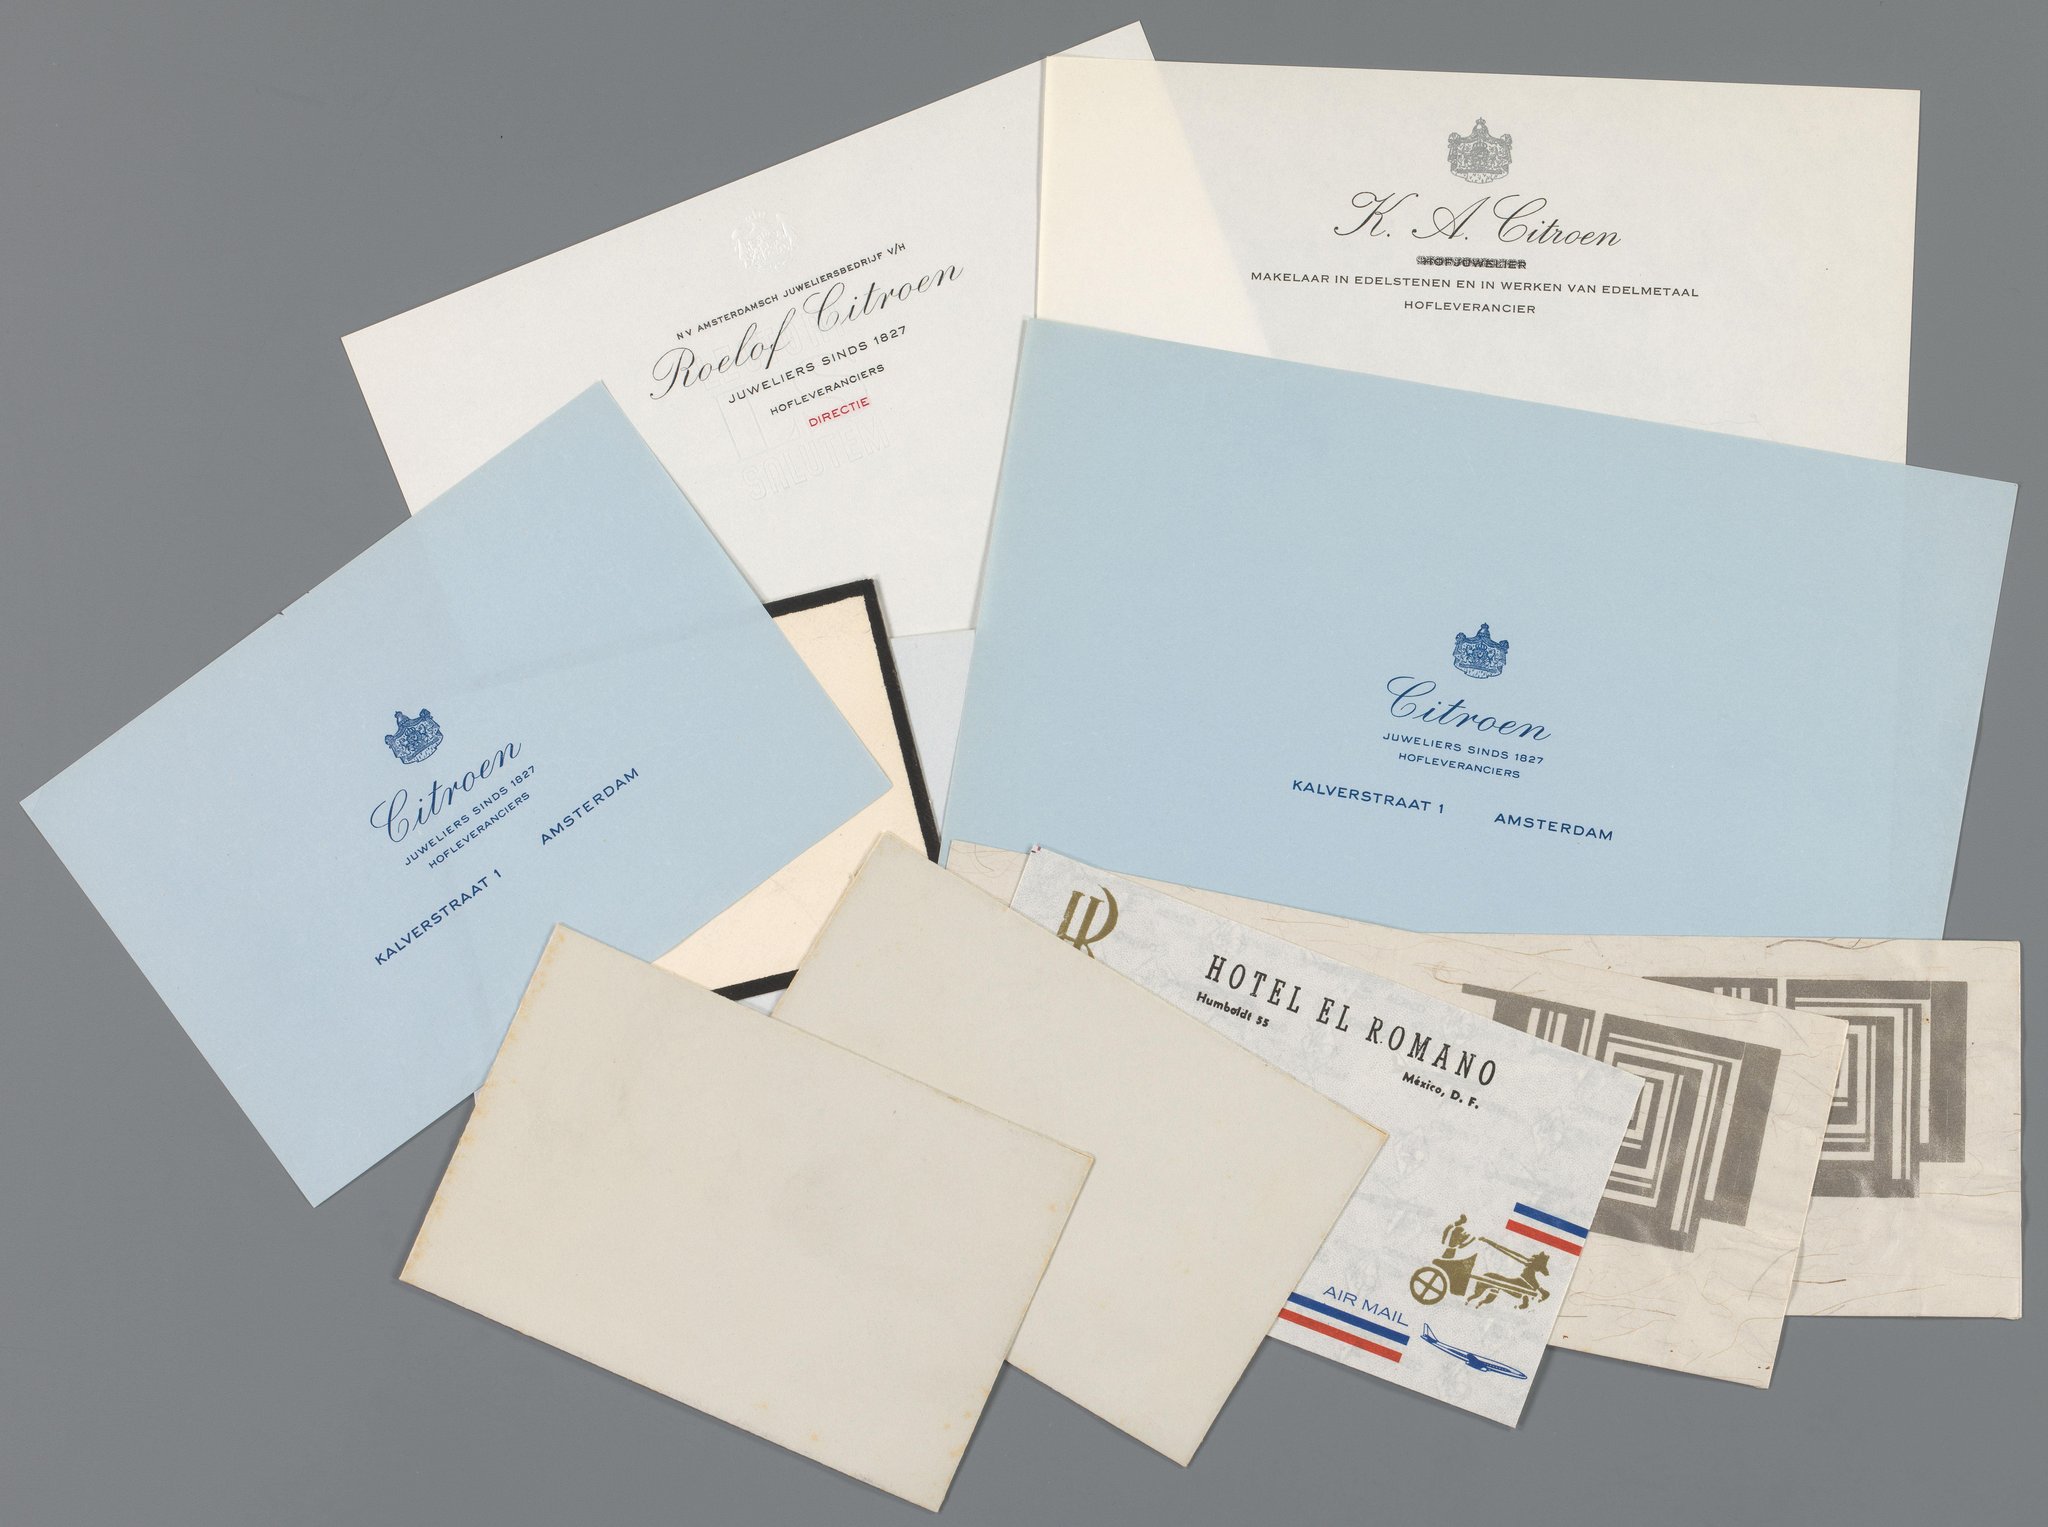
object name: stationery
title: Briefpapier en enveloppen, 11 stuks, enkele van de juweliers Citroen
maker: Anonymous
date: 1900-1950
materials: paper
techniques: printing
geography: netherlands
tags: oslo, juwelier, karel adolf citroen